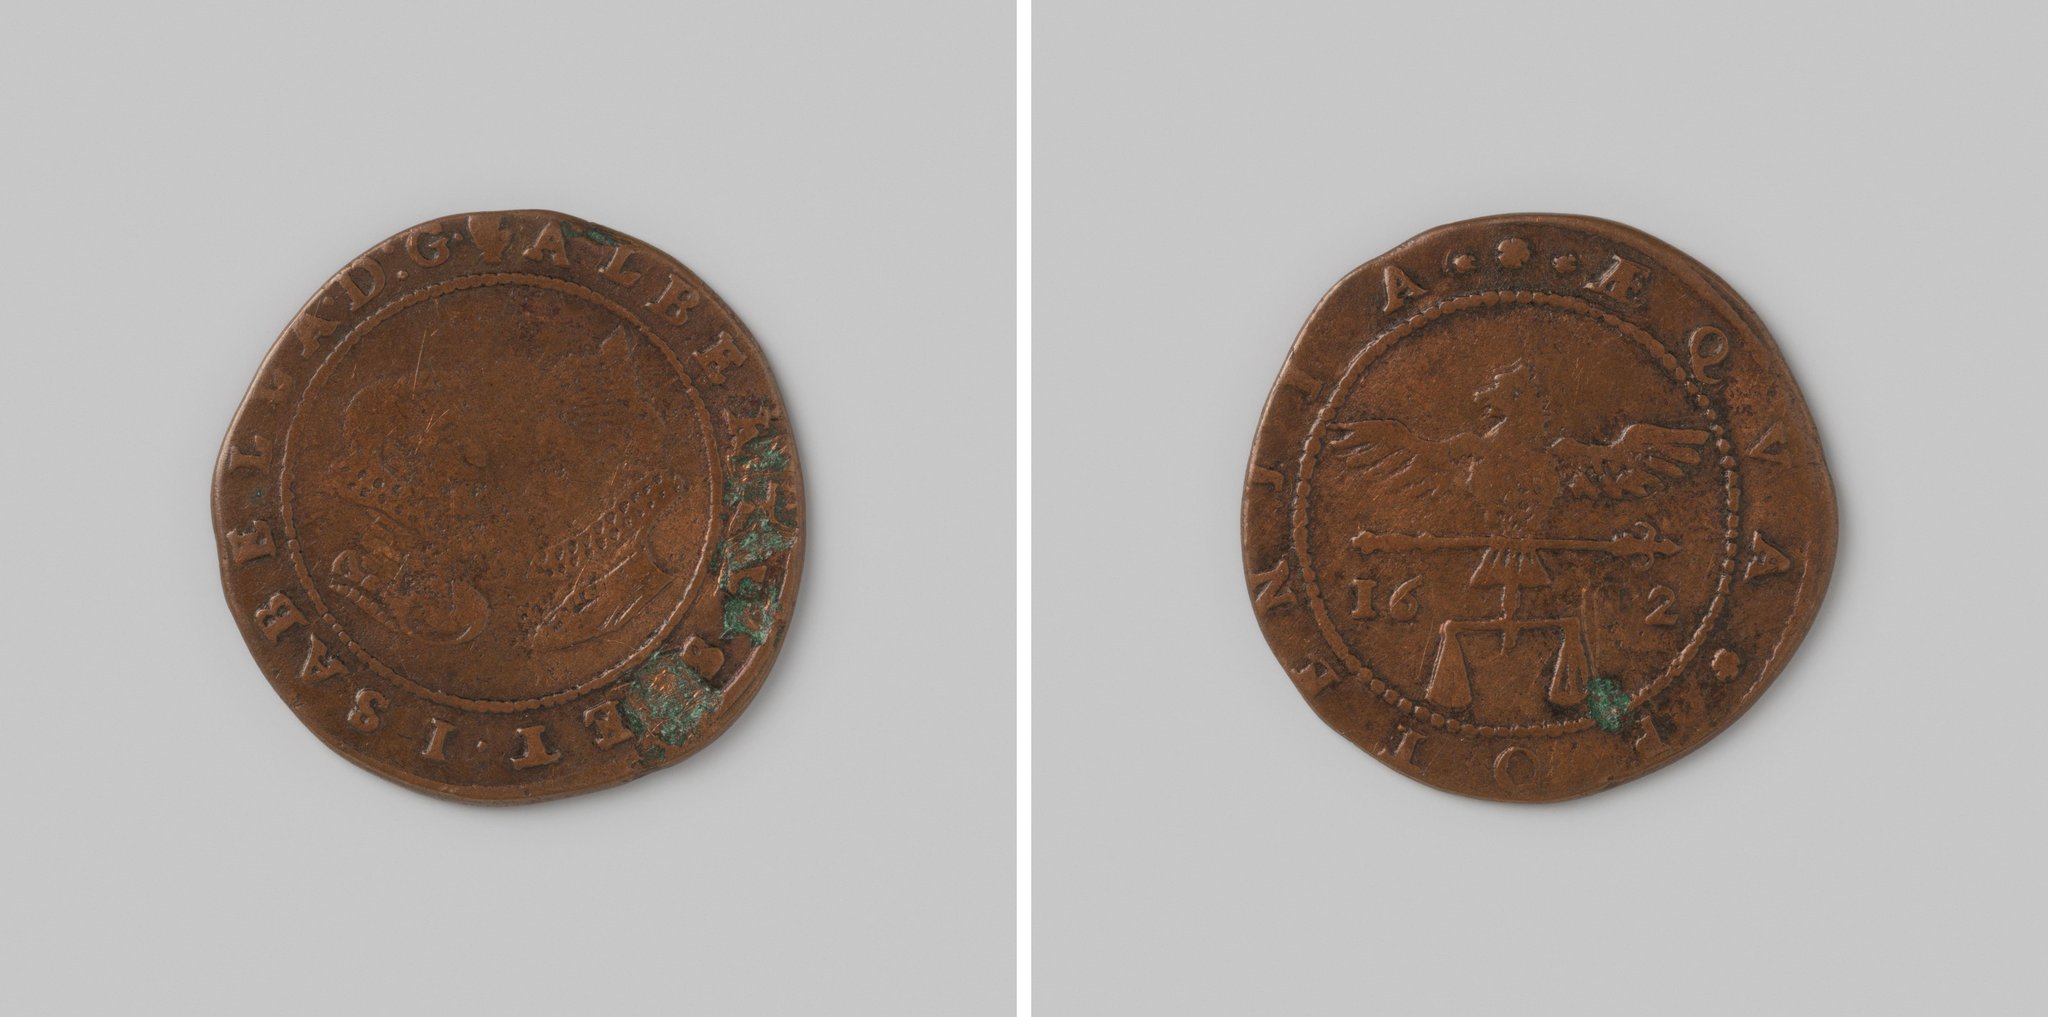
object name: history medal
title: Rekenpenning uit Antwerpen op de Rijksban op Aken 1612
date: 1612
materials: copper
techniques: striking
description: Koperen penning, op de voorzijde de elkaar toegewende borstbeelden van Albert en Isanella met omschrift, op de keerzijde een adelaar met scepter en weegschaal, met omschrift.